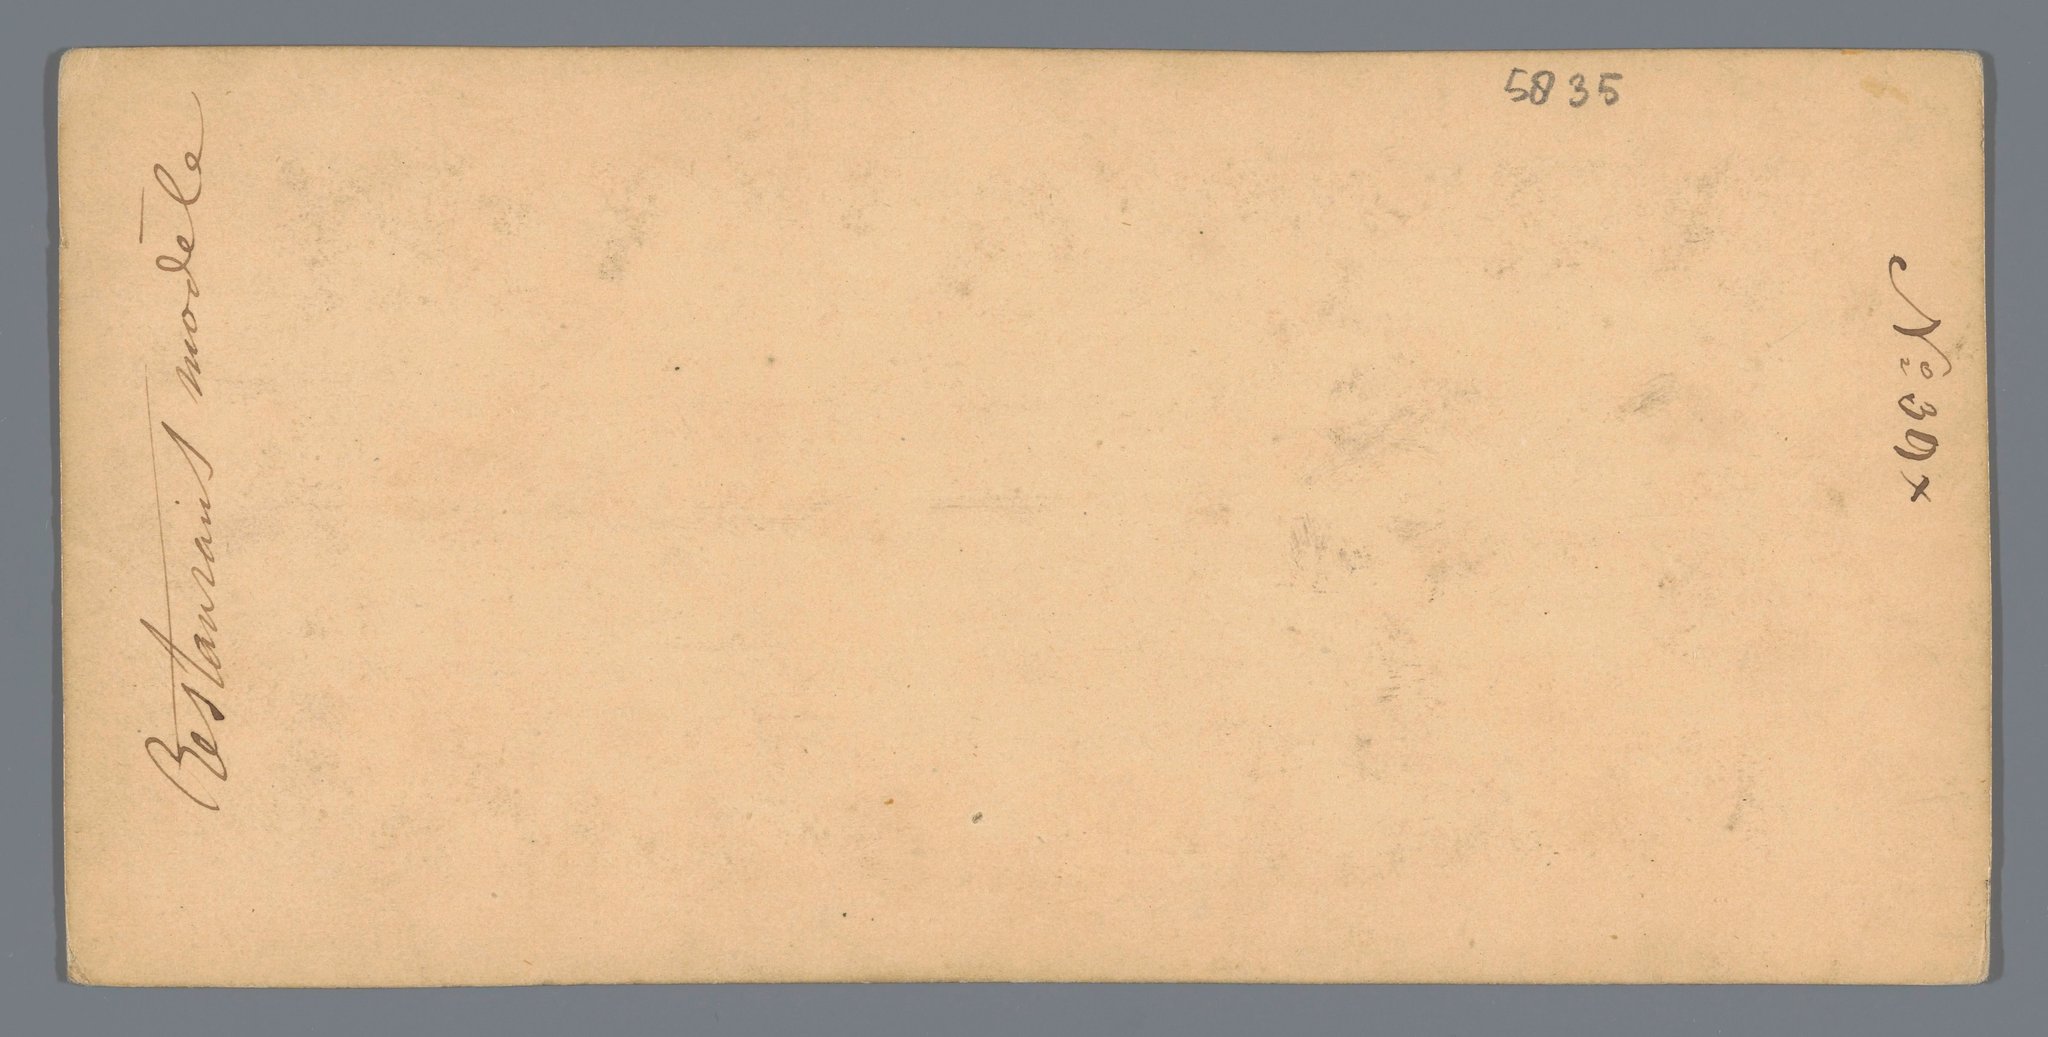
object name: stereograph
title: Interieur van een restaurant, vermoedelijk in Parijs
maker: Anonymous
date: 1855-1860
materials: cardboard, photographic support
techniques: albumen print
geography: paris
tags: restaurant, paris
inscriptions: number: ‘No. 39 x’, inscription: ‘Restaurant modéle’